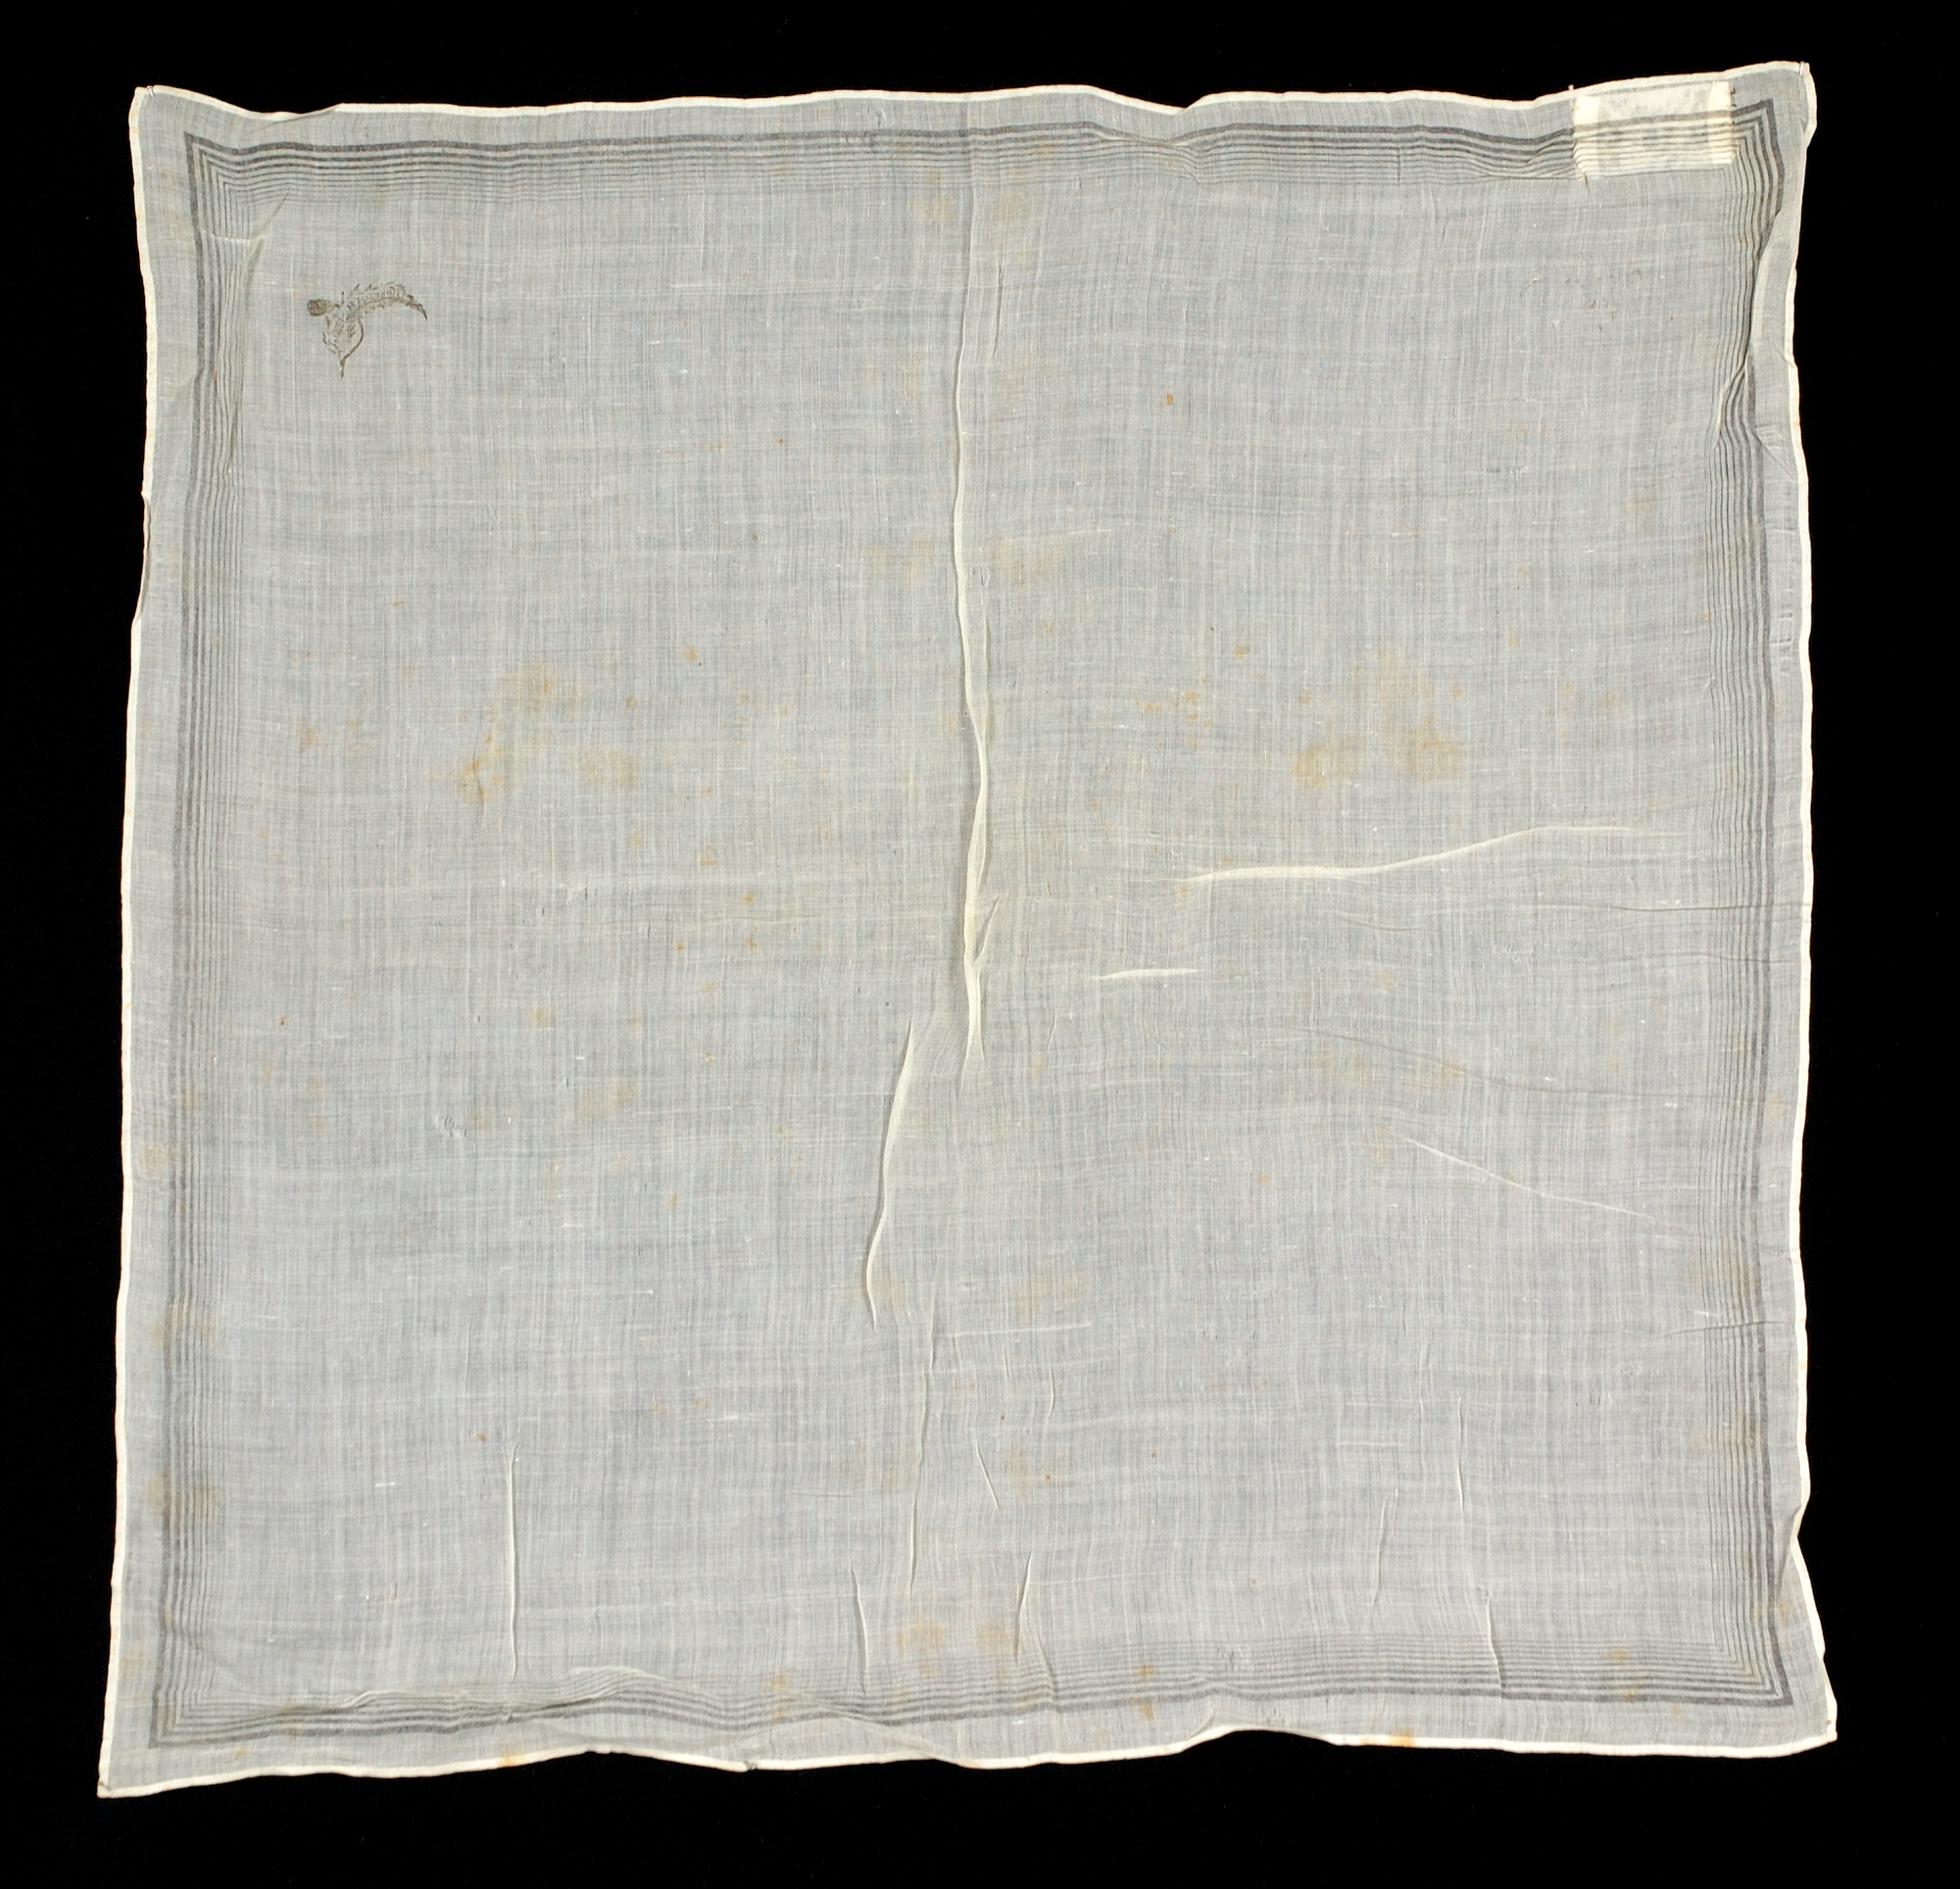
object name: handkerchief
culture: american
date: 1851-1875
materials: linen